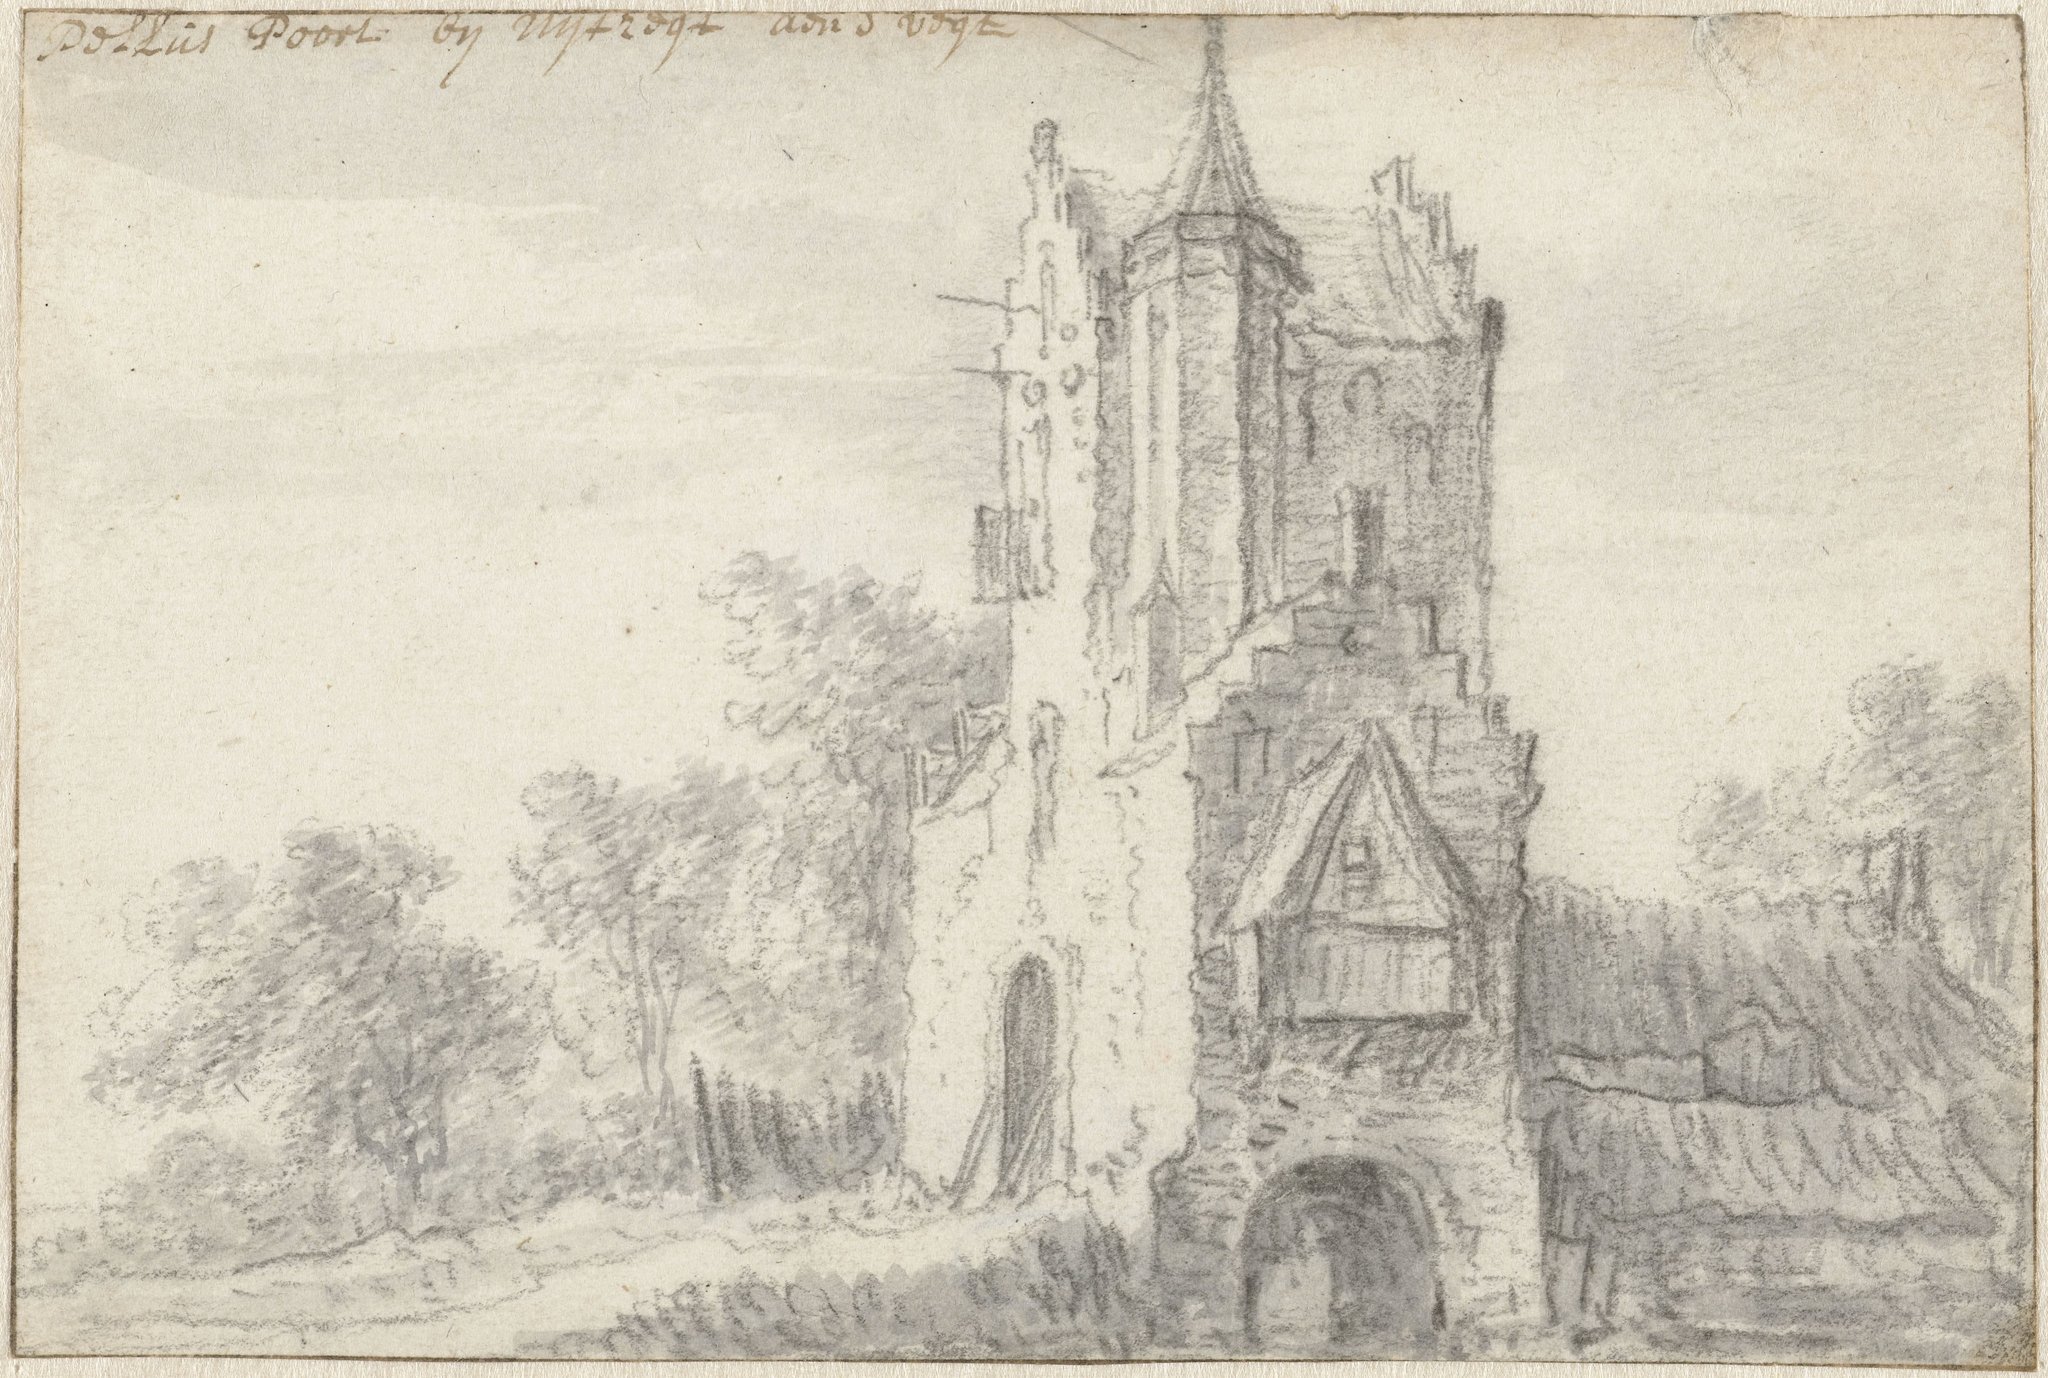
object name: drawing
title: Pelluspoort of Pellecussenpoort bij Utrecht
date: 1619-1690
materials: chalk, paper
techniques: brush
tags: city-gate, utrecht